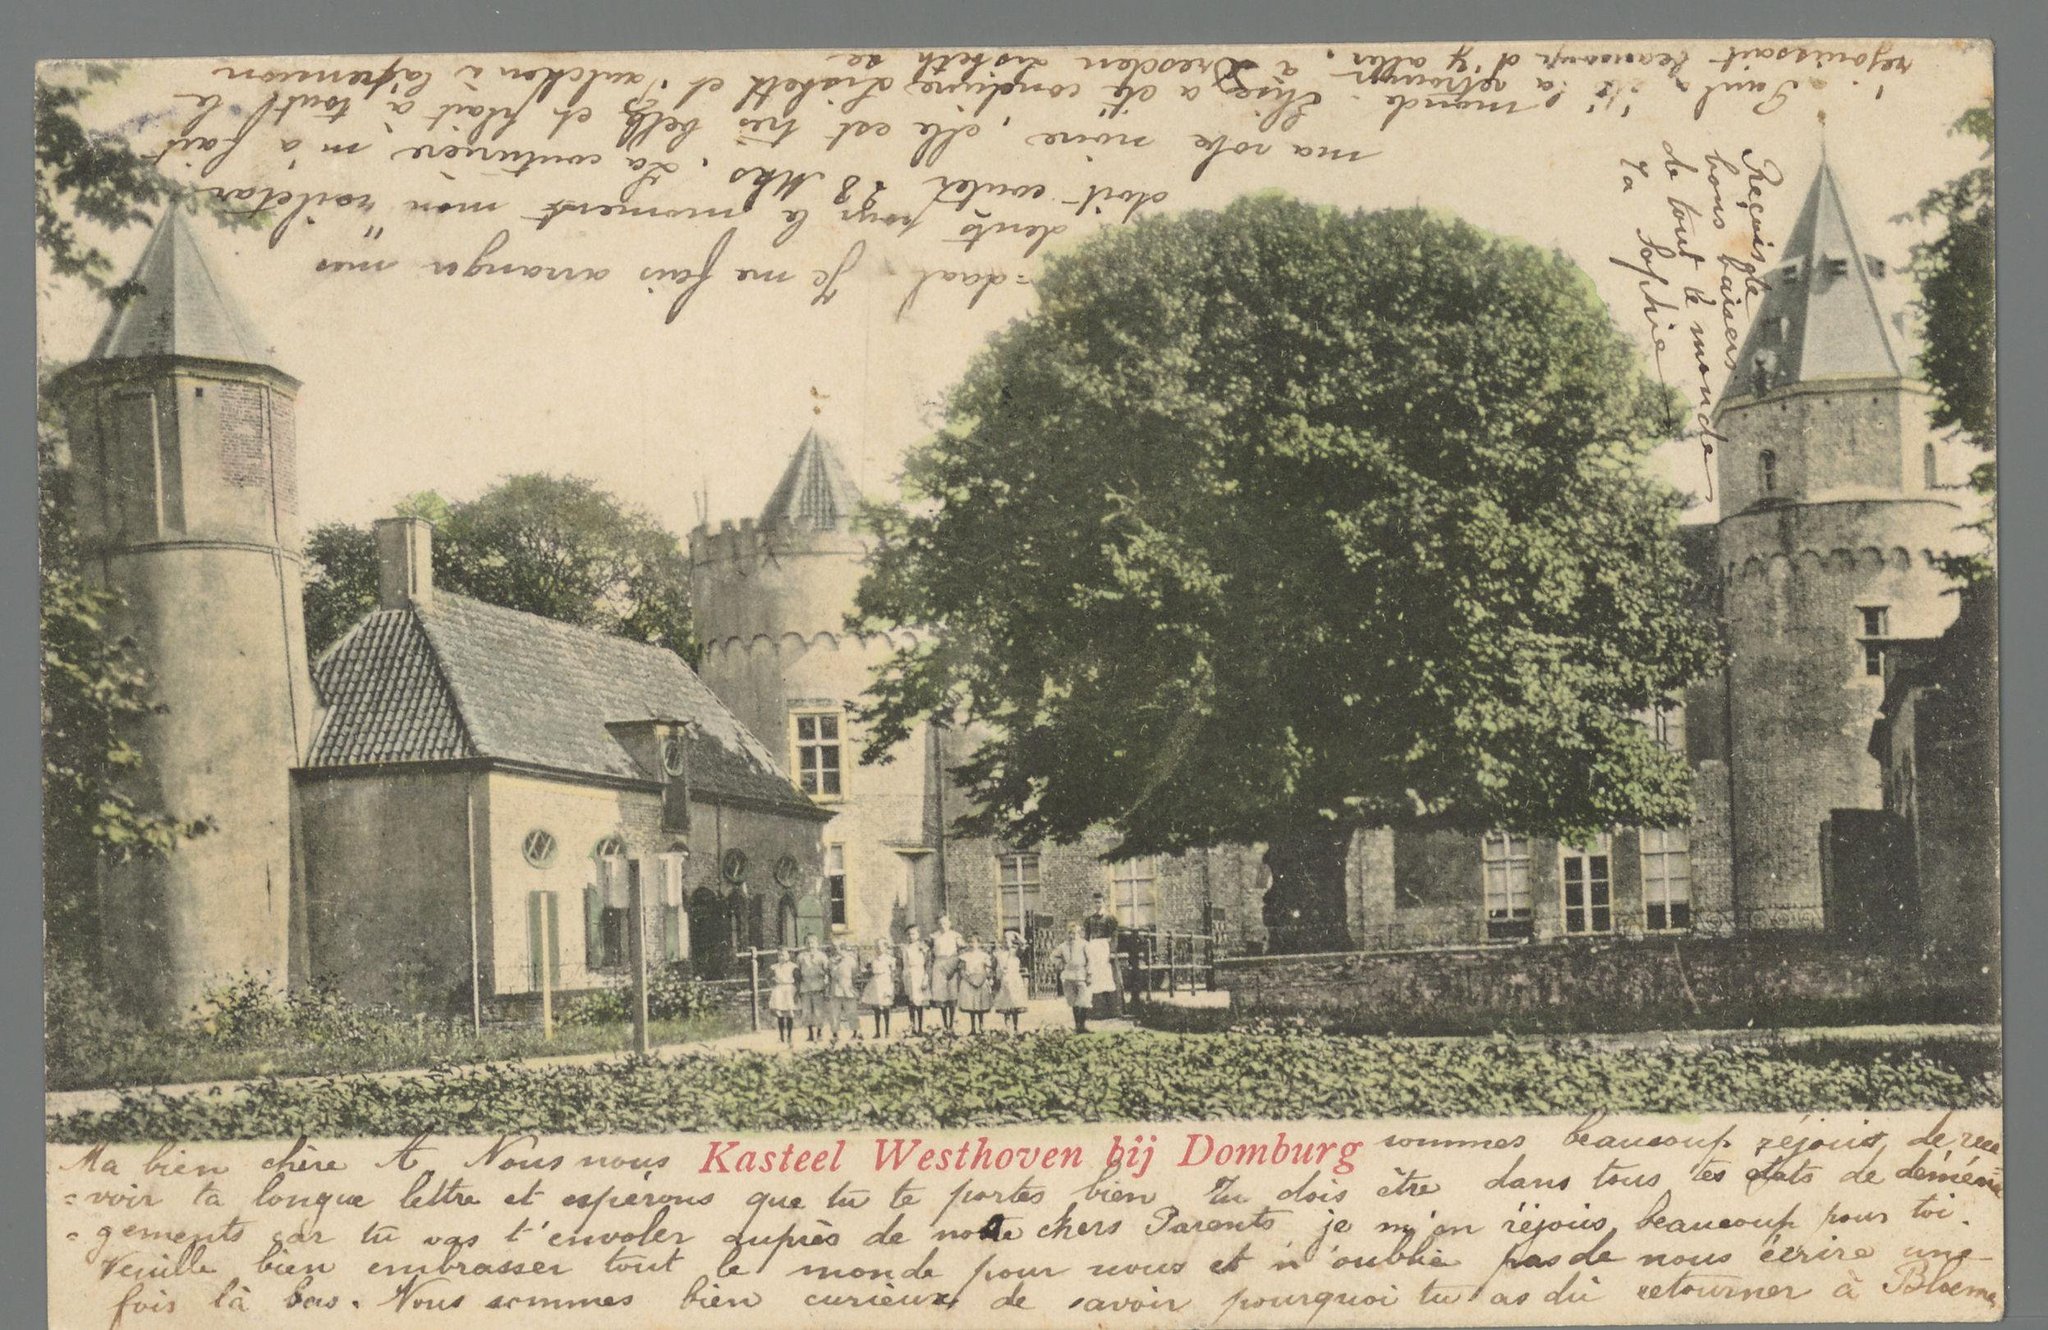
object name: photomechanical print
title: Kasteel Westhoven bij Domburg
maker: Anonymous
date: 1897-1903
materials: cardboard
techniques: photograph, hand coloring, writing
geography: oostkapelle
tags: castle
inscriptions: postage stamp